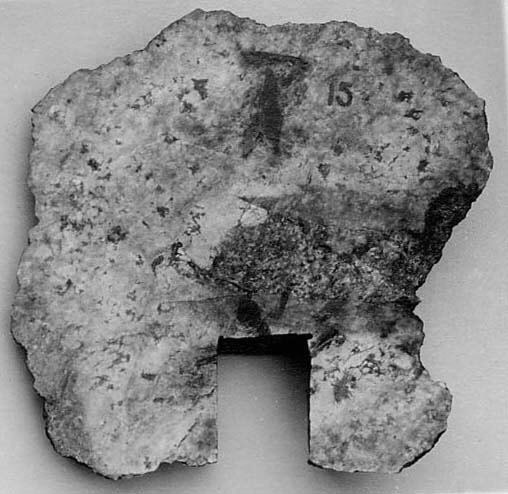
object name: slab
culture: burmese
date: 1902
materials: jade